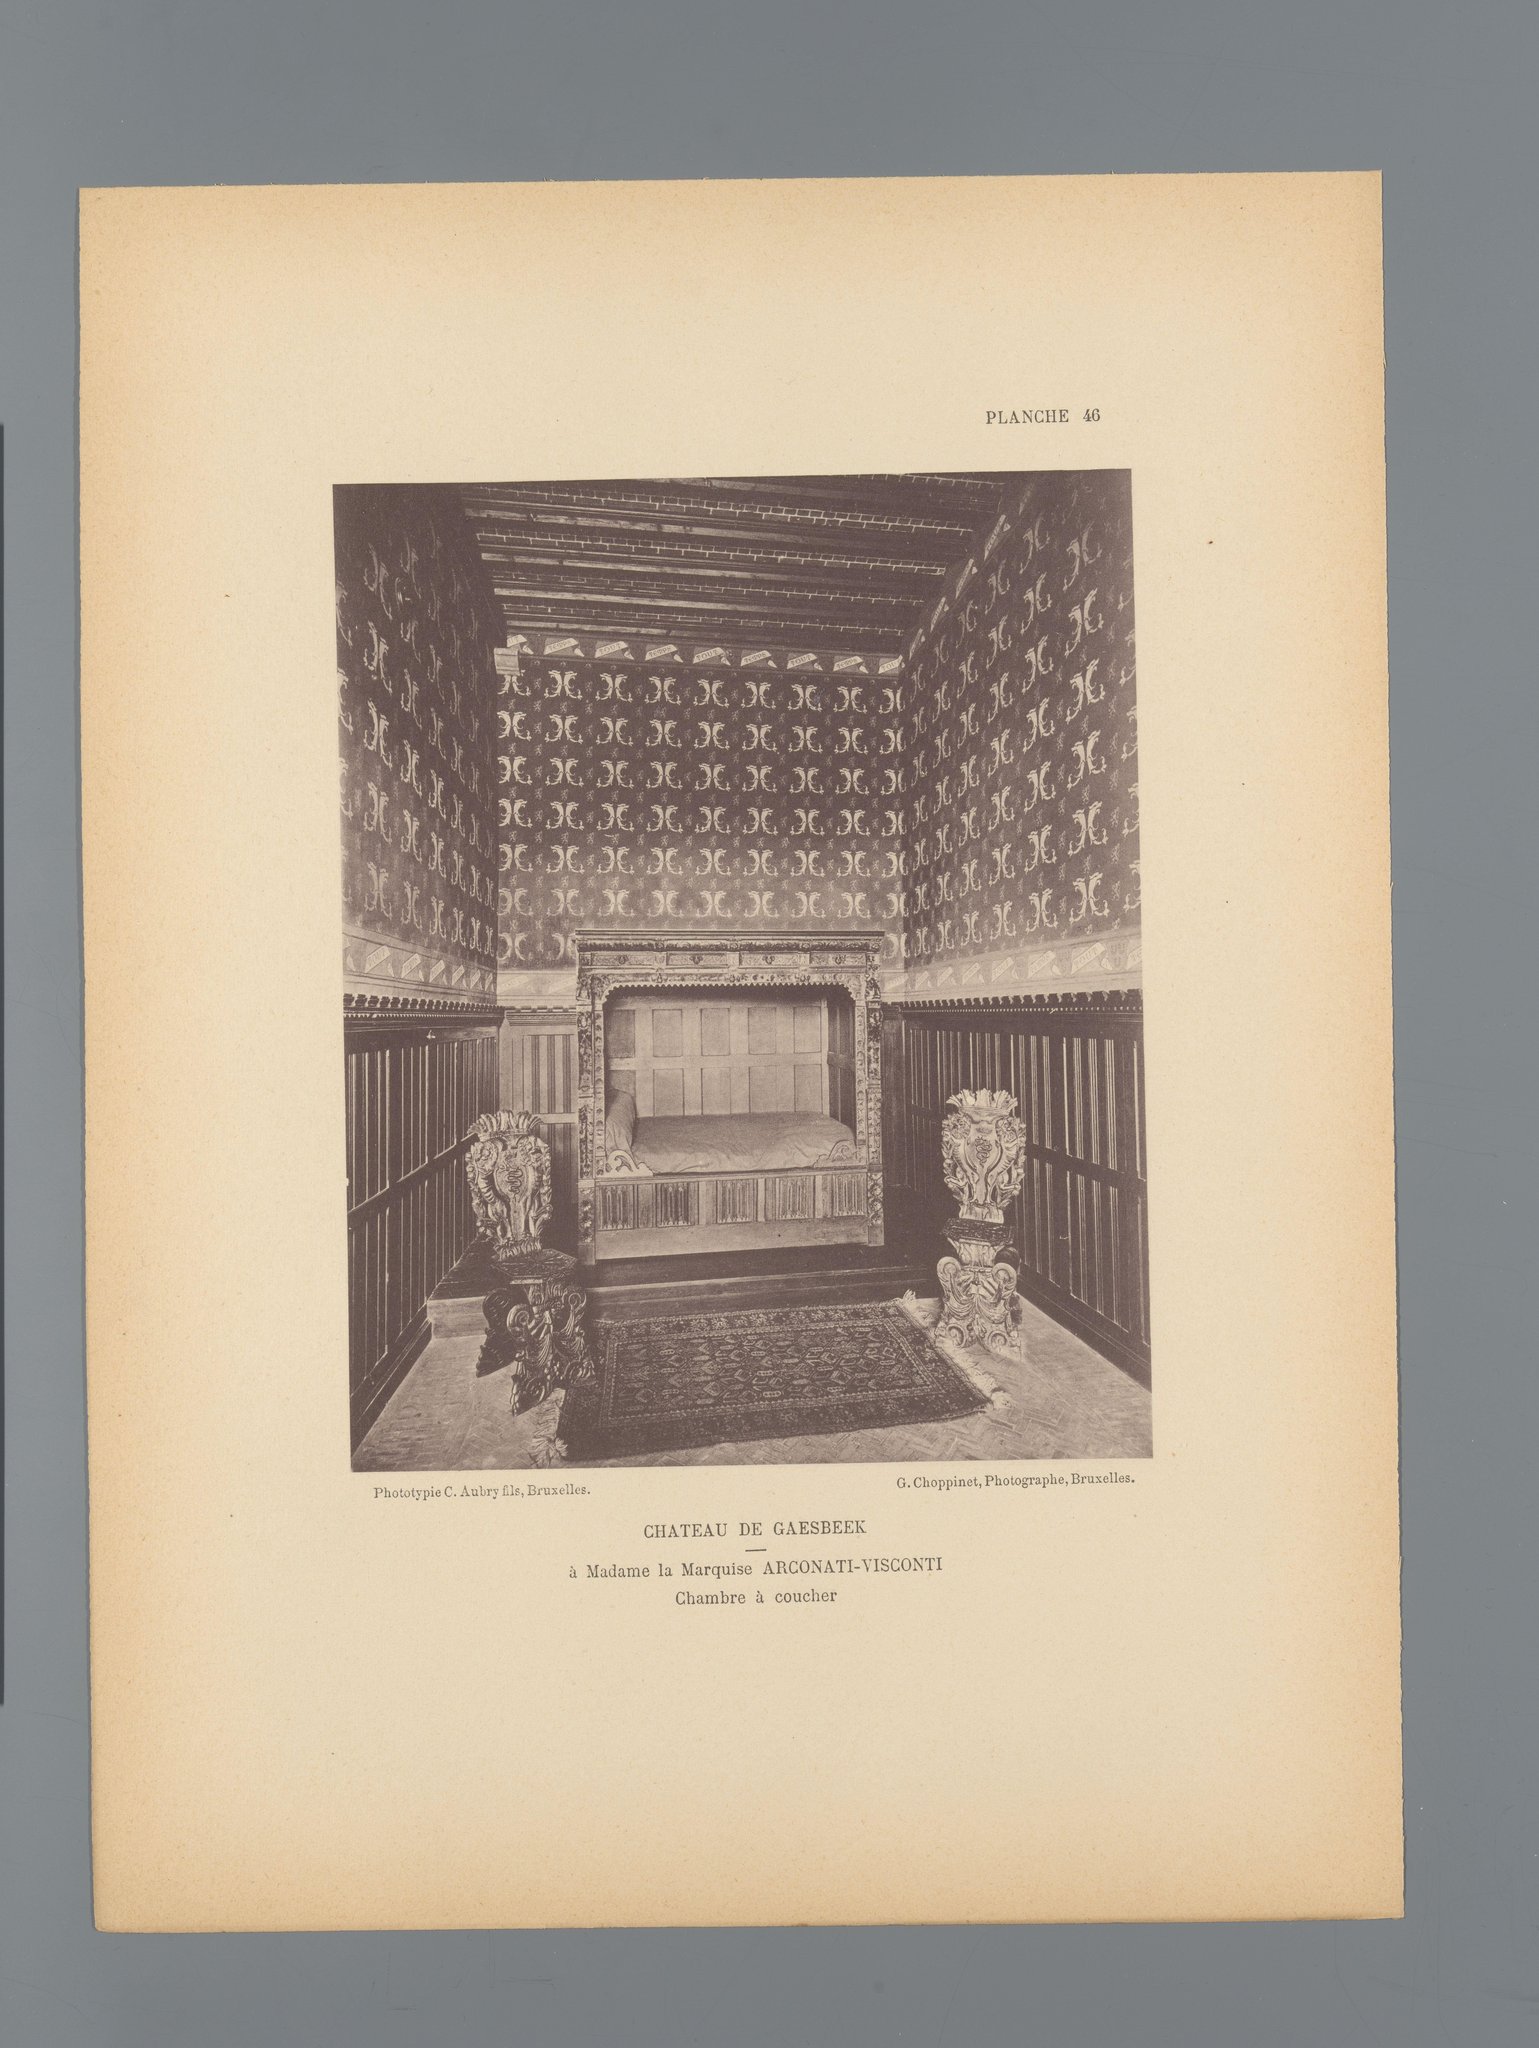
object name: photomechanical print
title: Gezicht op een slaapkamer in het Kasteel van Gaasbeek, België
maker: gustave choppinet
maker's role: fotograaf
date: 1893-1898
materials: paper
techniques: photograph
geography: kasteel van gaasbeek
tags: castle, bedroom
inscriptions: inscription: ‘à Madame la Marquise ARCONATI-VISCONTI/ Chambre à coucher’, number: ‘PLANCHE 46’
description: Deze prent maakt deel uit van een omslag met 89 prenten en 5 tekstbladen.